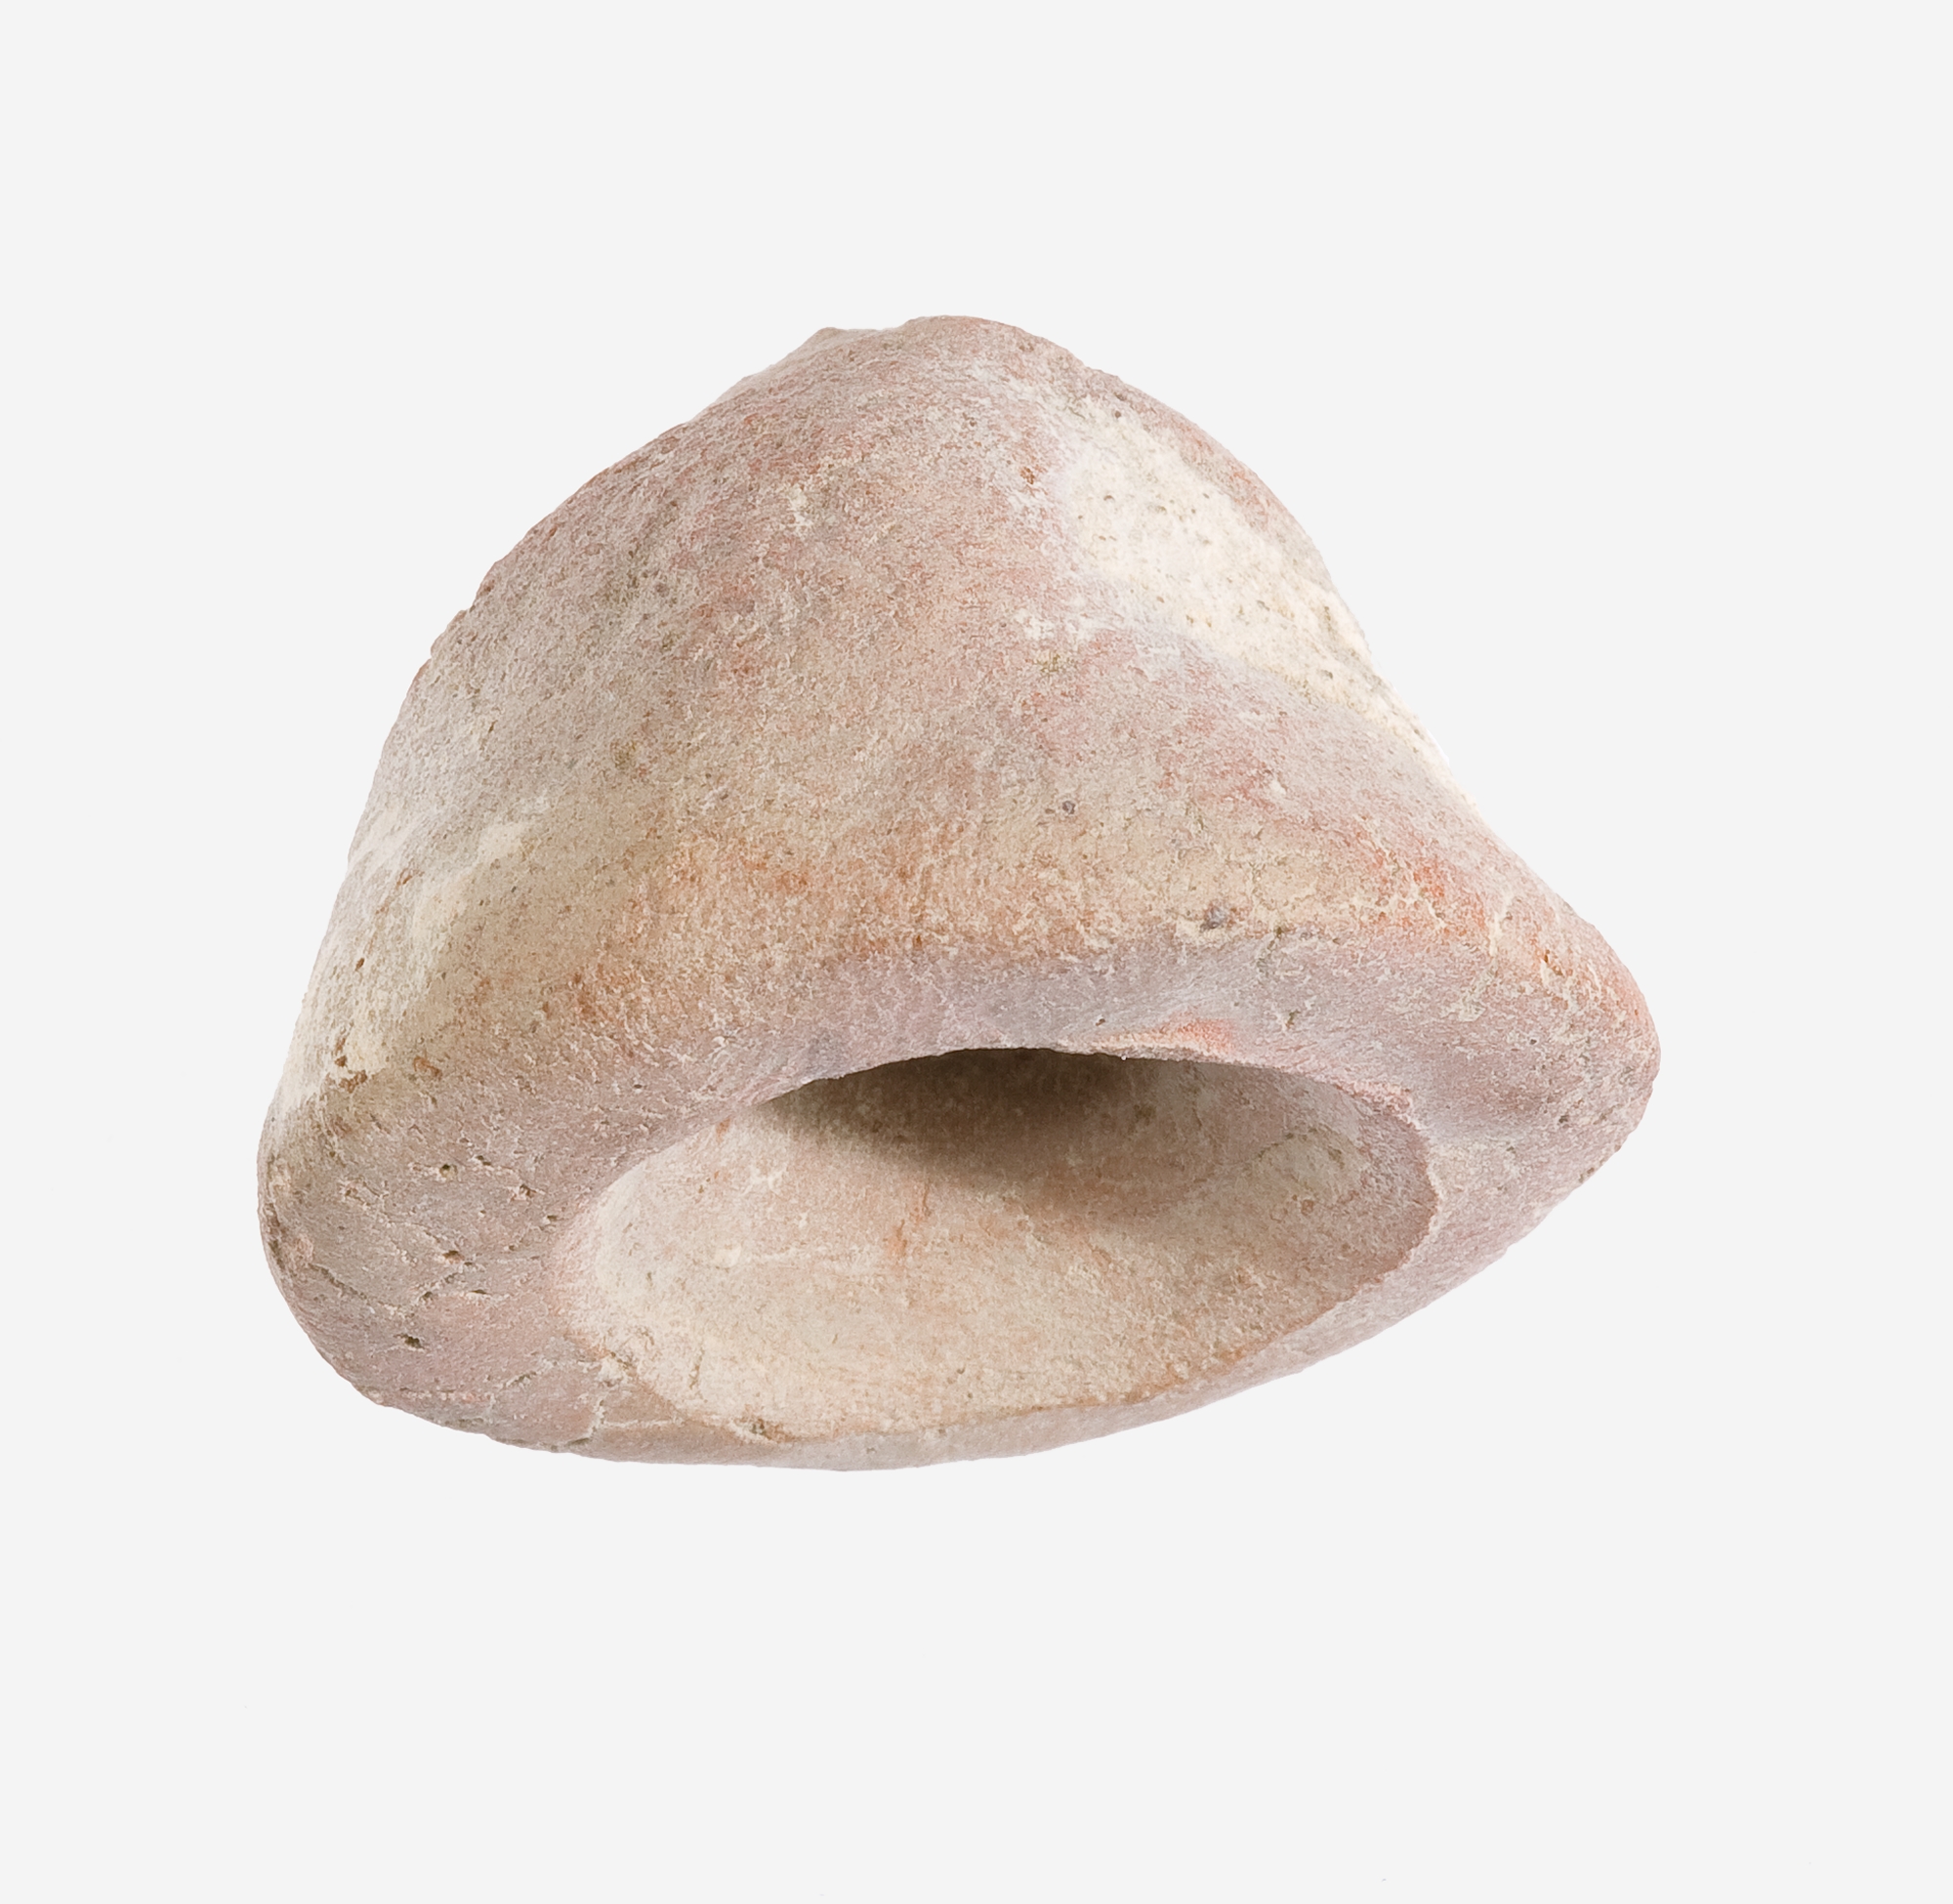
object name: mold, cornflower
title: Umbel Mold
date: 1390-1352 BCE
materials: pottery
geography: egypt